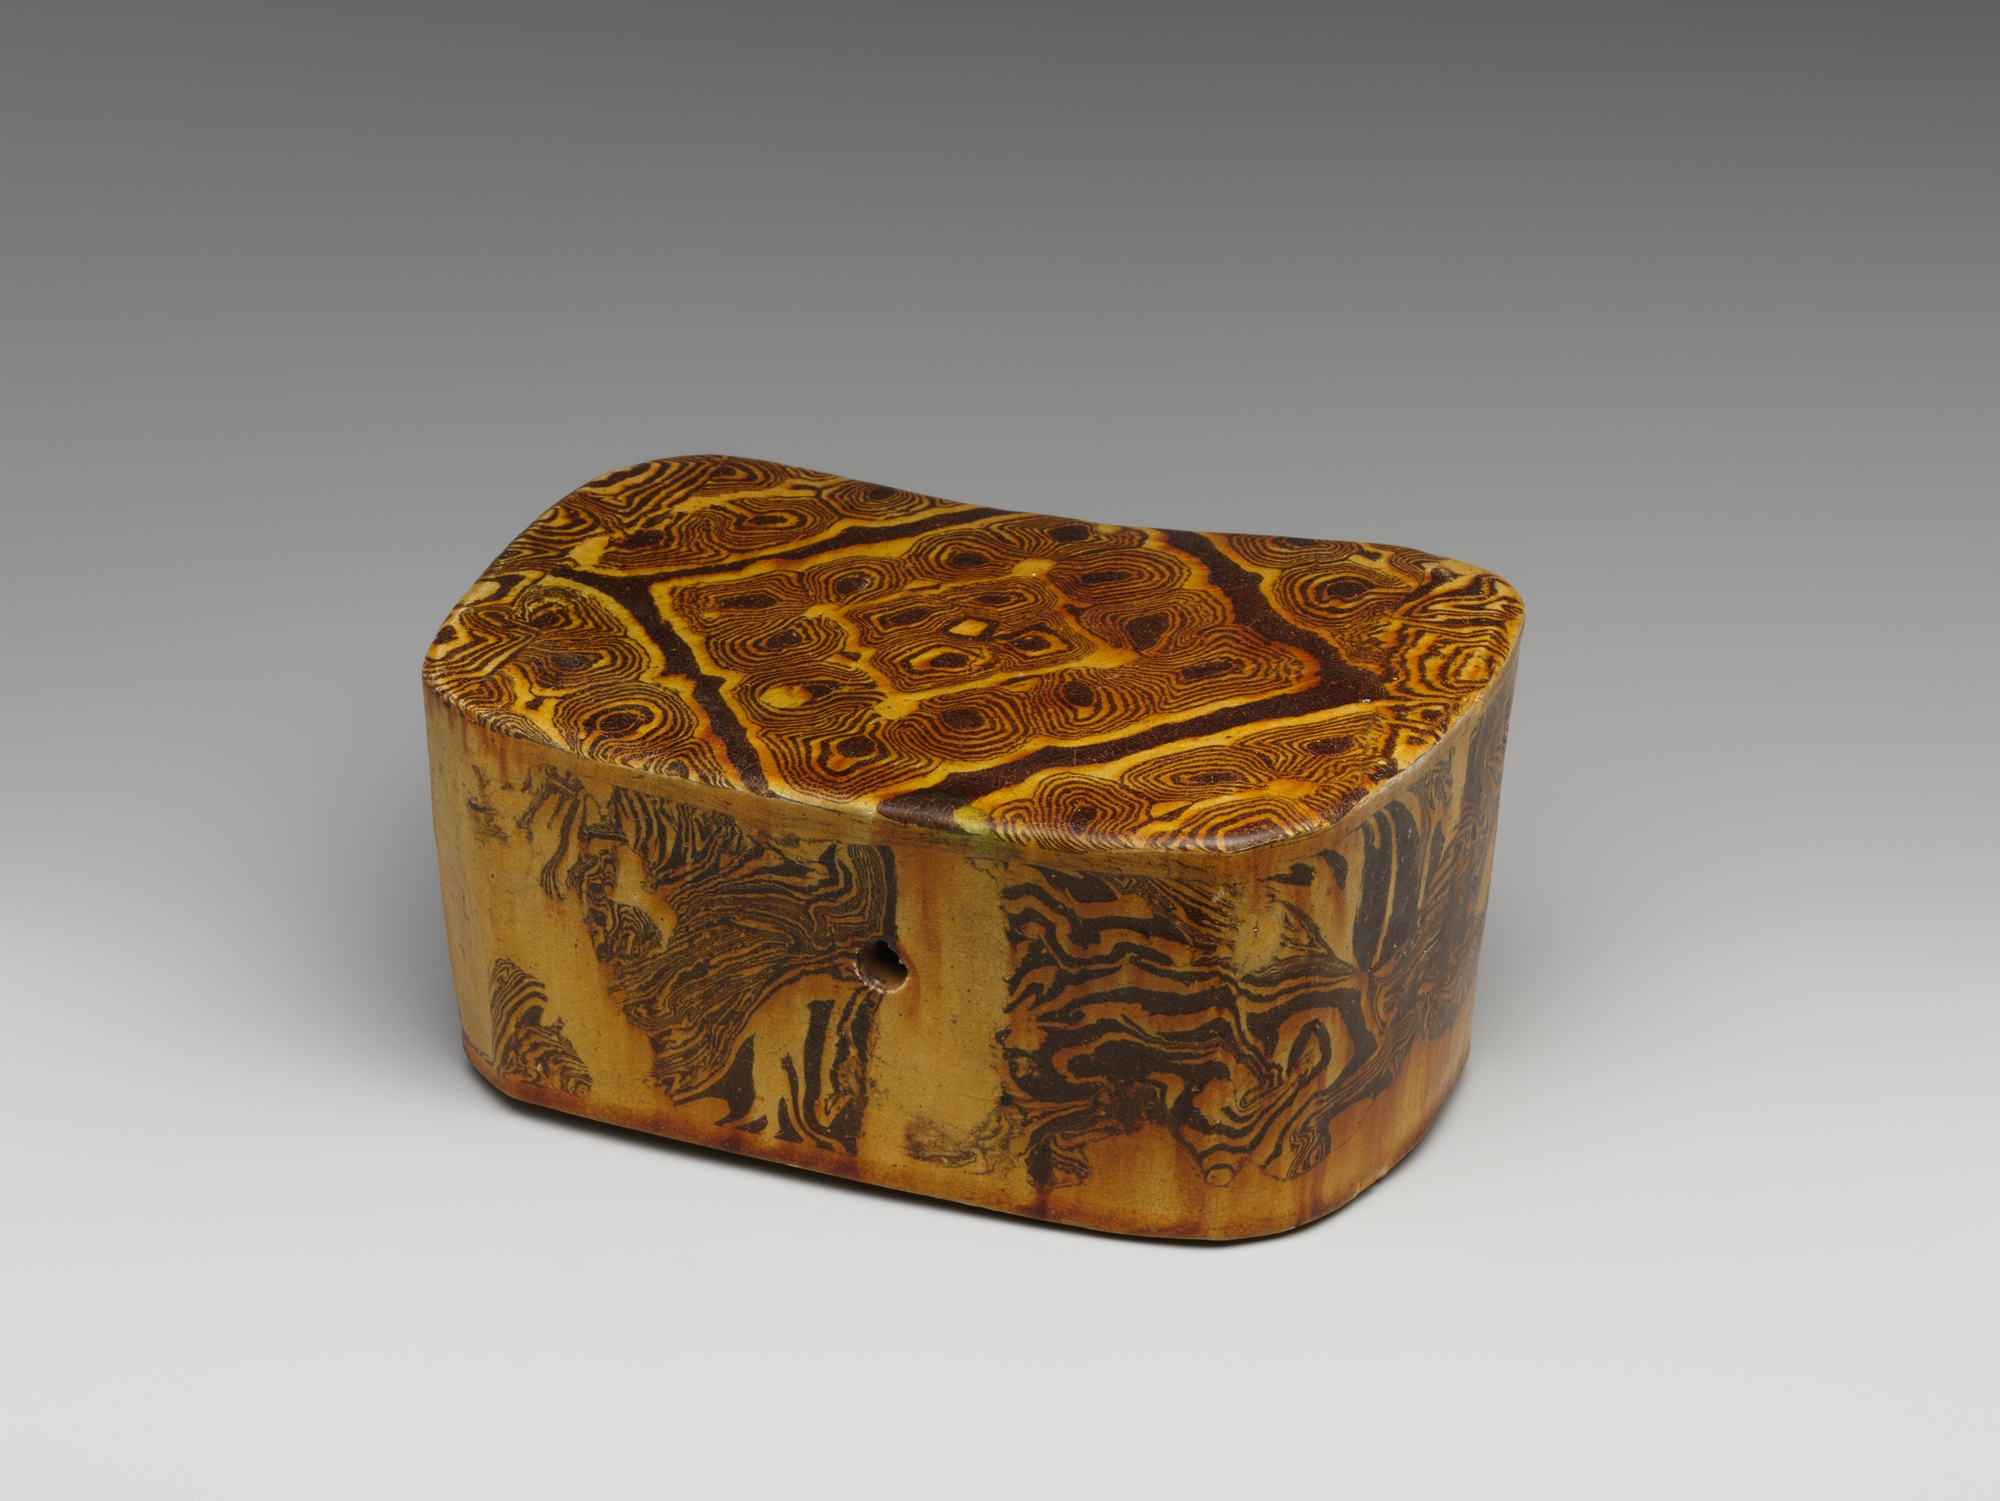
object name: pillow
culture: chinese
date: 701-800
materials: earthenware, glaze, marble